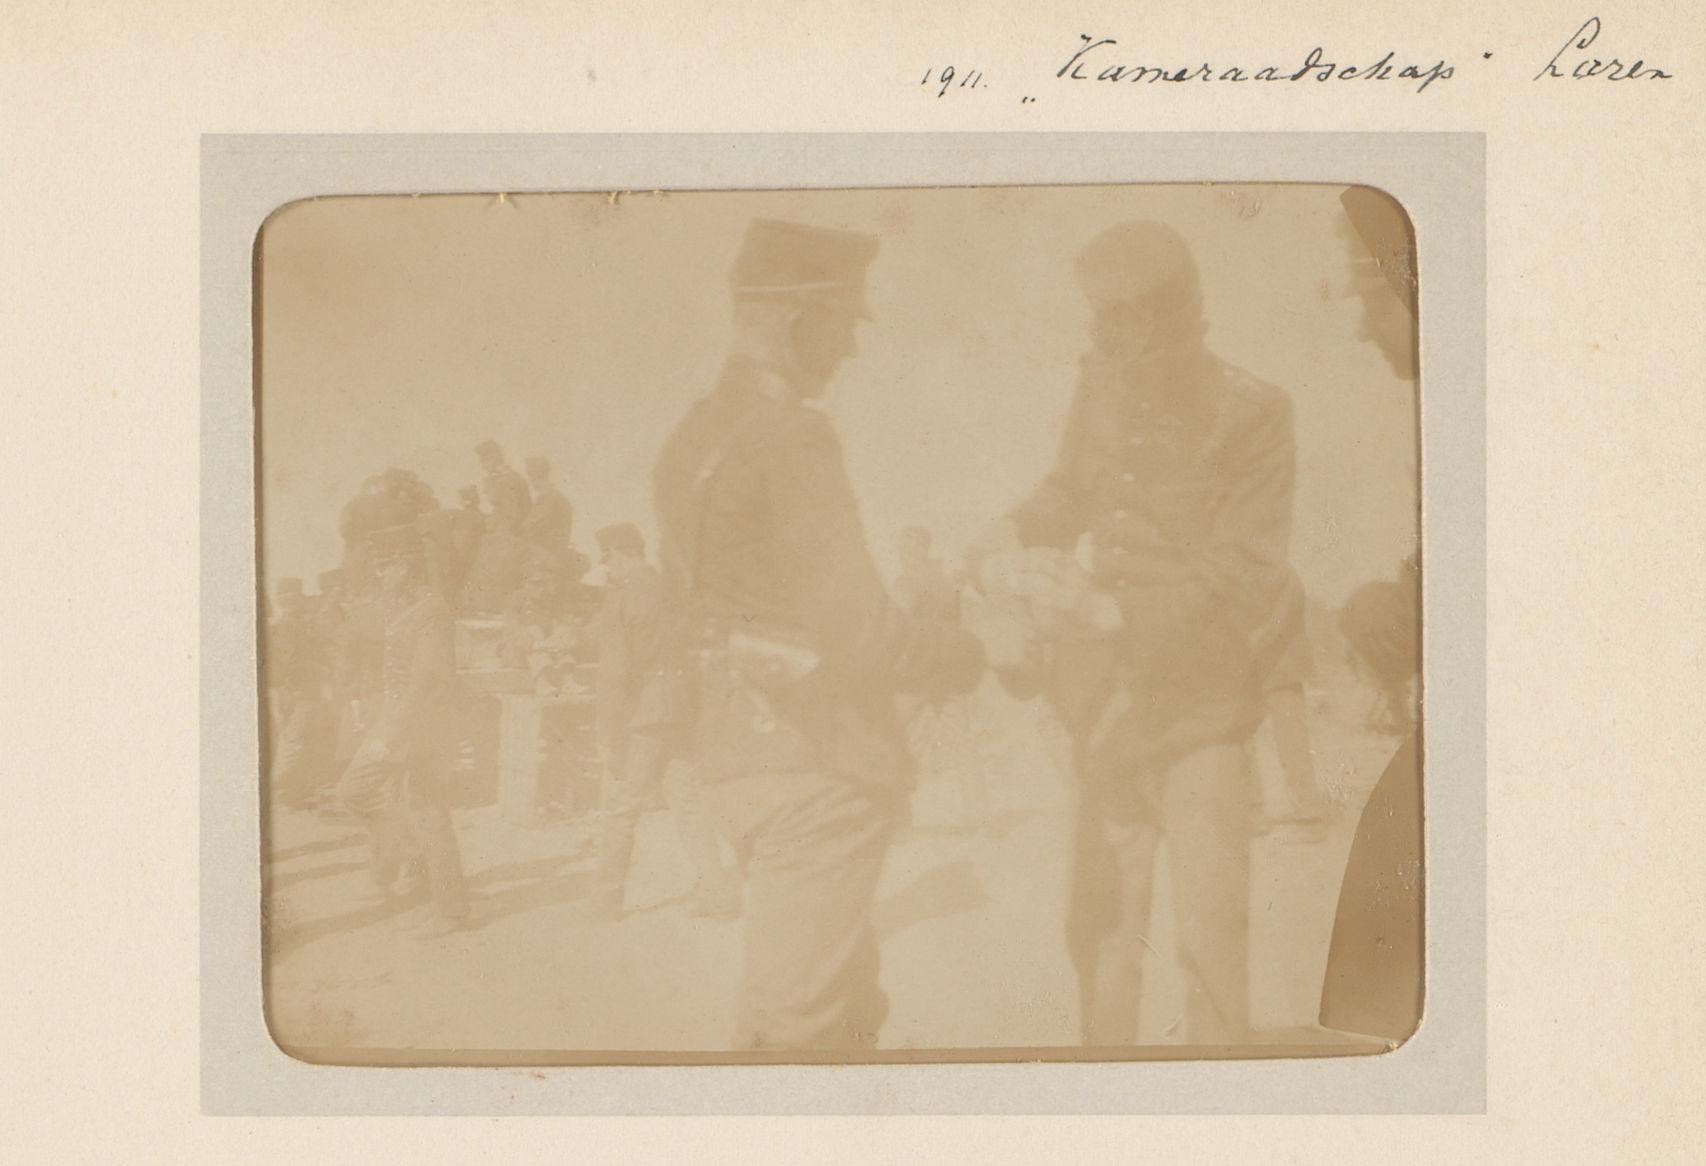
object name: photograph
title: Twee mannen in militair uniform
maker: liesbeth overhoff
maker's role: fotograaf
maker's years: 1895-1969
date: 1911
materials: paper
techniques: gelatin silver print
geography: laren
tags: adult man, (military) uniforms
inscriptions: inscription: ‘1911 "Kameraadschap" Laren’